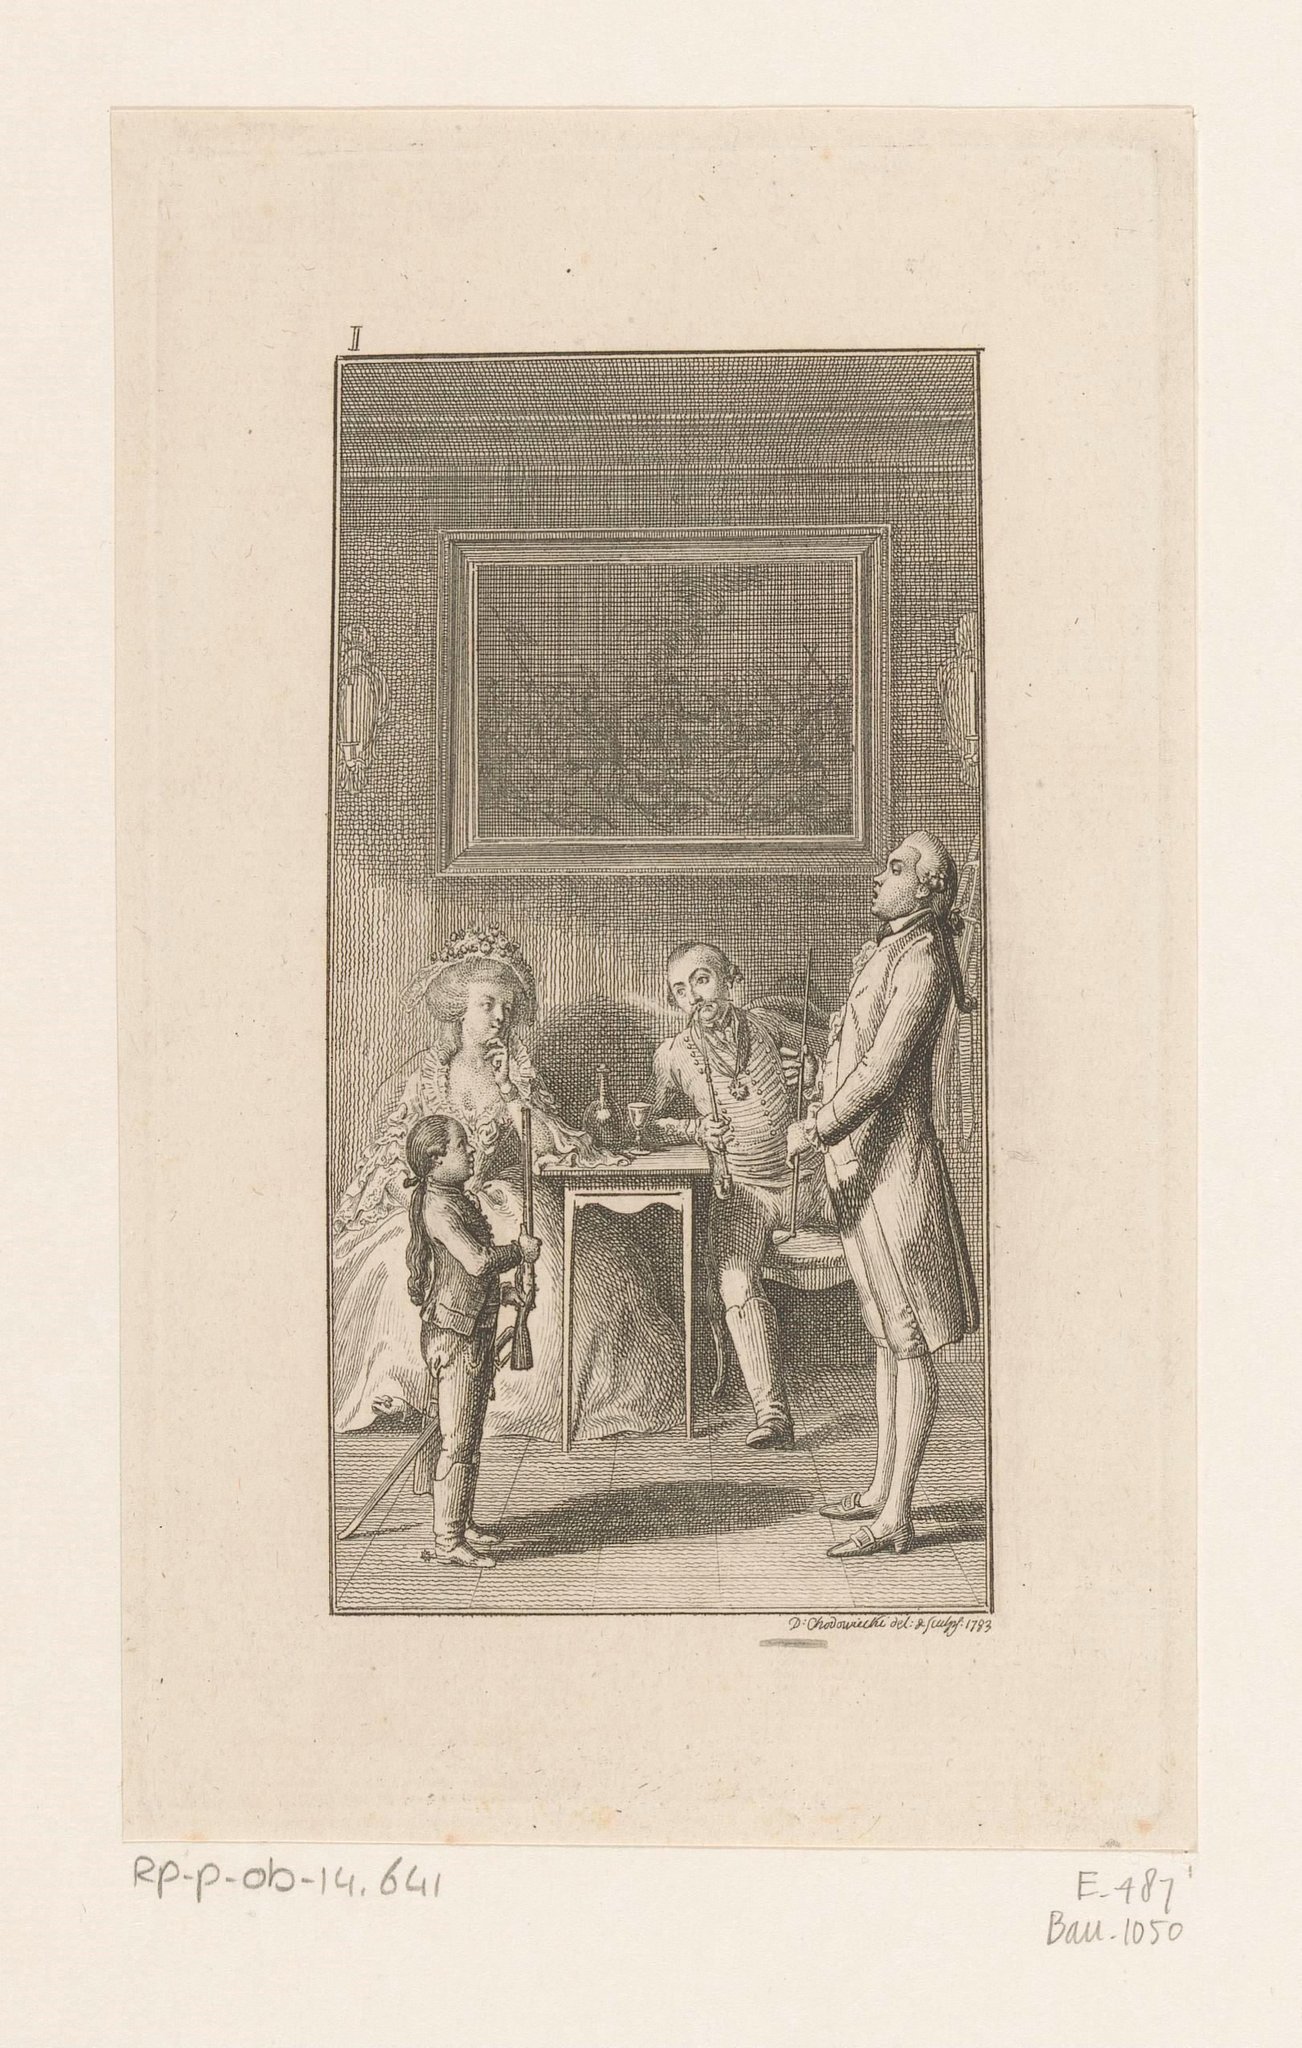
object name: print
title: Siegfried von Lindenberg krijgt van zijn bediende les over wapens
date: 1783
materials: paper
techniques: etching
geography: berlin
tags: parents with their children, literature, knighthood order, pipe ~ tobacco, hacking and thrusting weapons: sword, firearms: rifle, interior of the house, house personnel, servants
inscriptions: collector's mark: Lugt 2228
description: Prent uit: Müller, Johann Gottwerth. Siegfried von Lindenberg [..]. 3de druk. 4 dln. Leipzig: Carl Friedrich Schneidern, 1784, dl. 1.